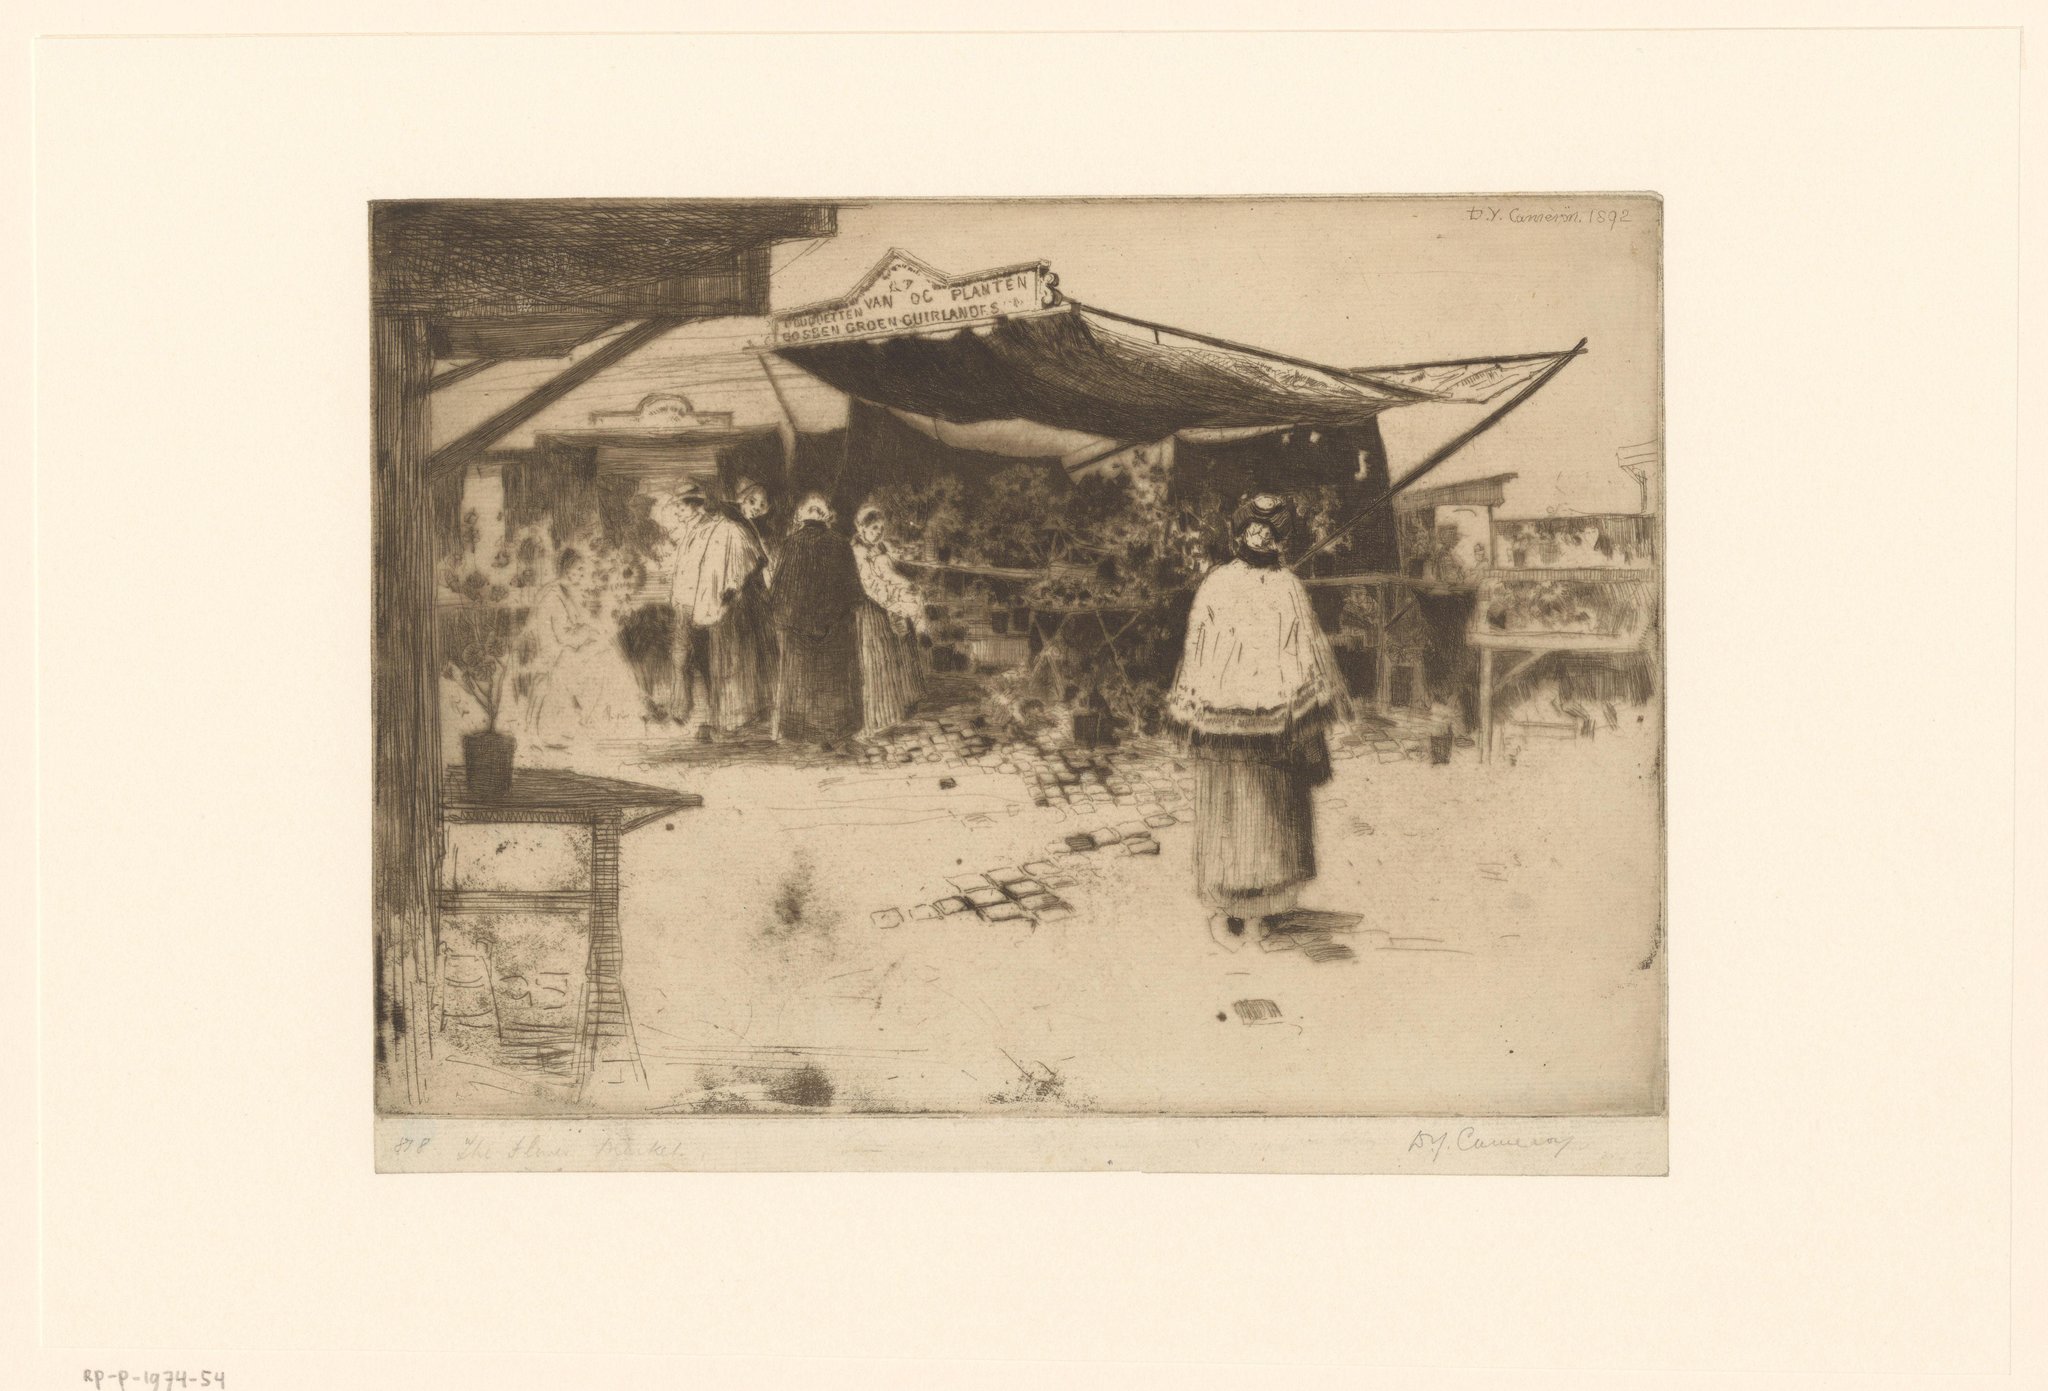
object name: print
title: Etchings in North Holland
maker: david young cameron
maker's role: draughtsman, print maker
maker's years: 1865-1945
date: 1892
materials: paper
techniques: drypoint, etching, intaglio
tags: flowers, stall, booth (~ market), haarlem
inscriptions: collector's mark: Lugt 2760, collector's mark: Lugt 2228